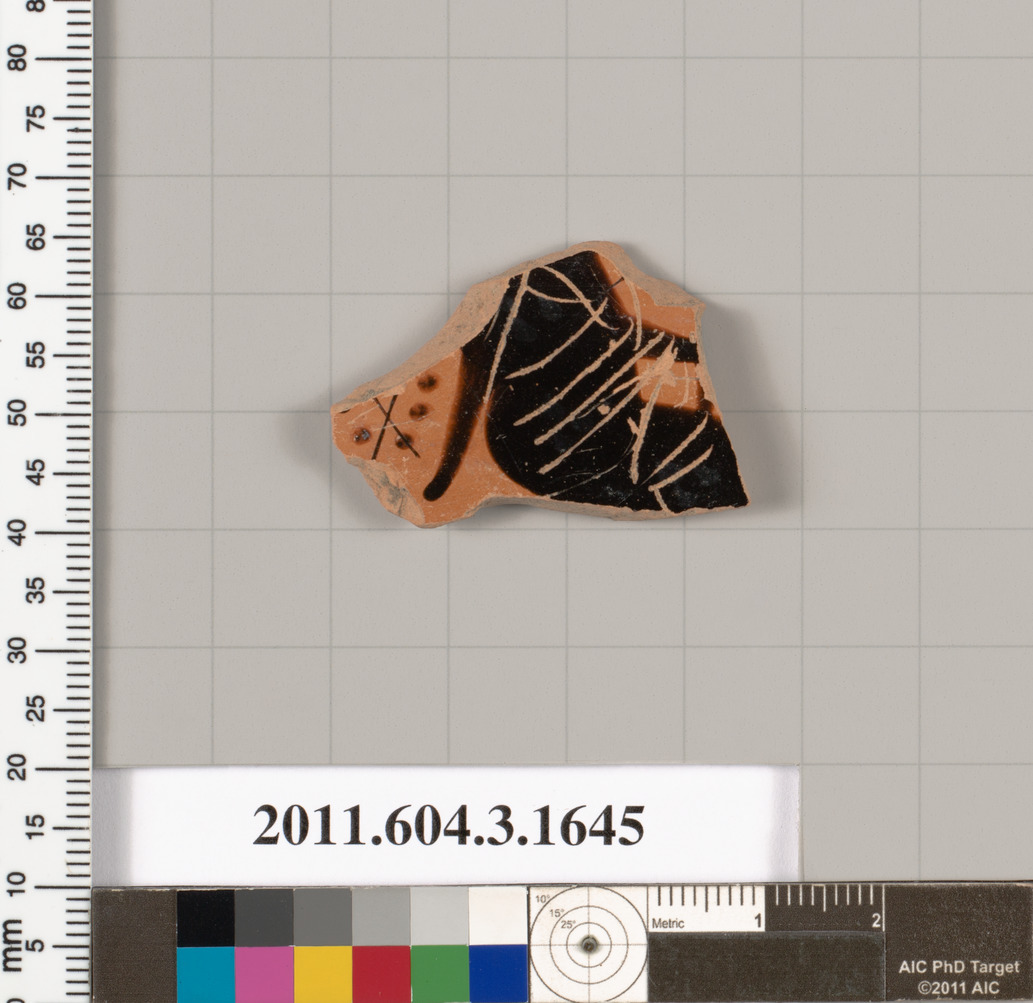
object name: kylix fragment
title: Terracotta fragment of a kylix: Band cup (drinking cup)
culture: greek, attic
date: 534-468 BCE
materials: terracotta